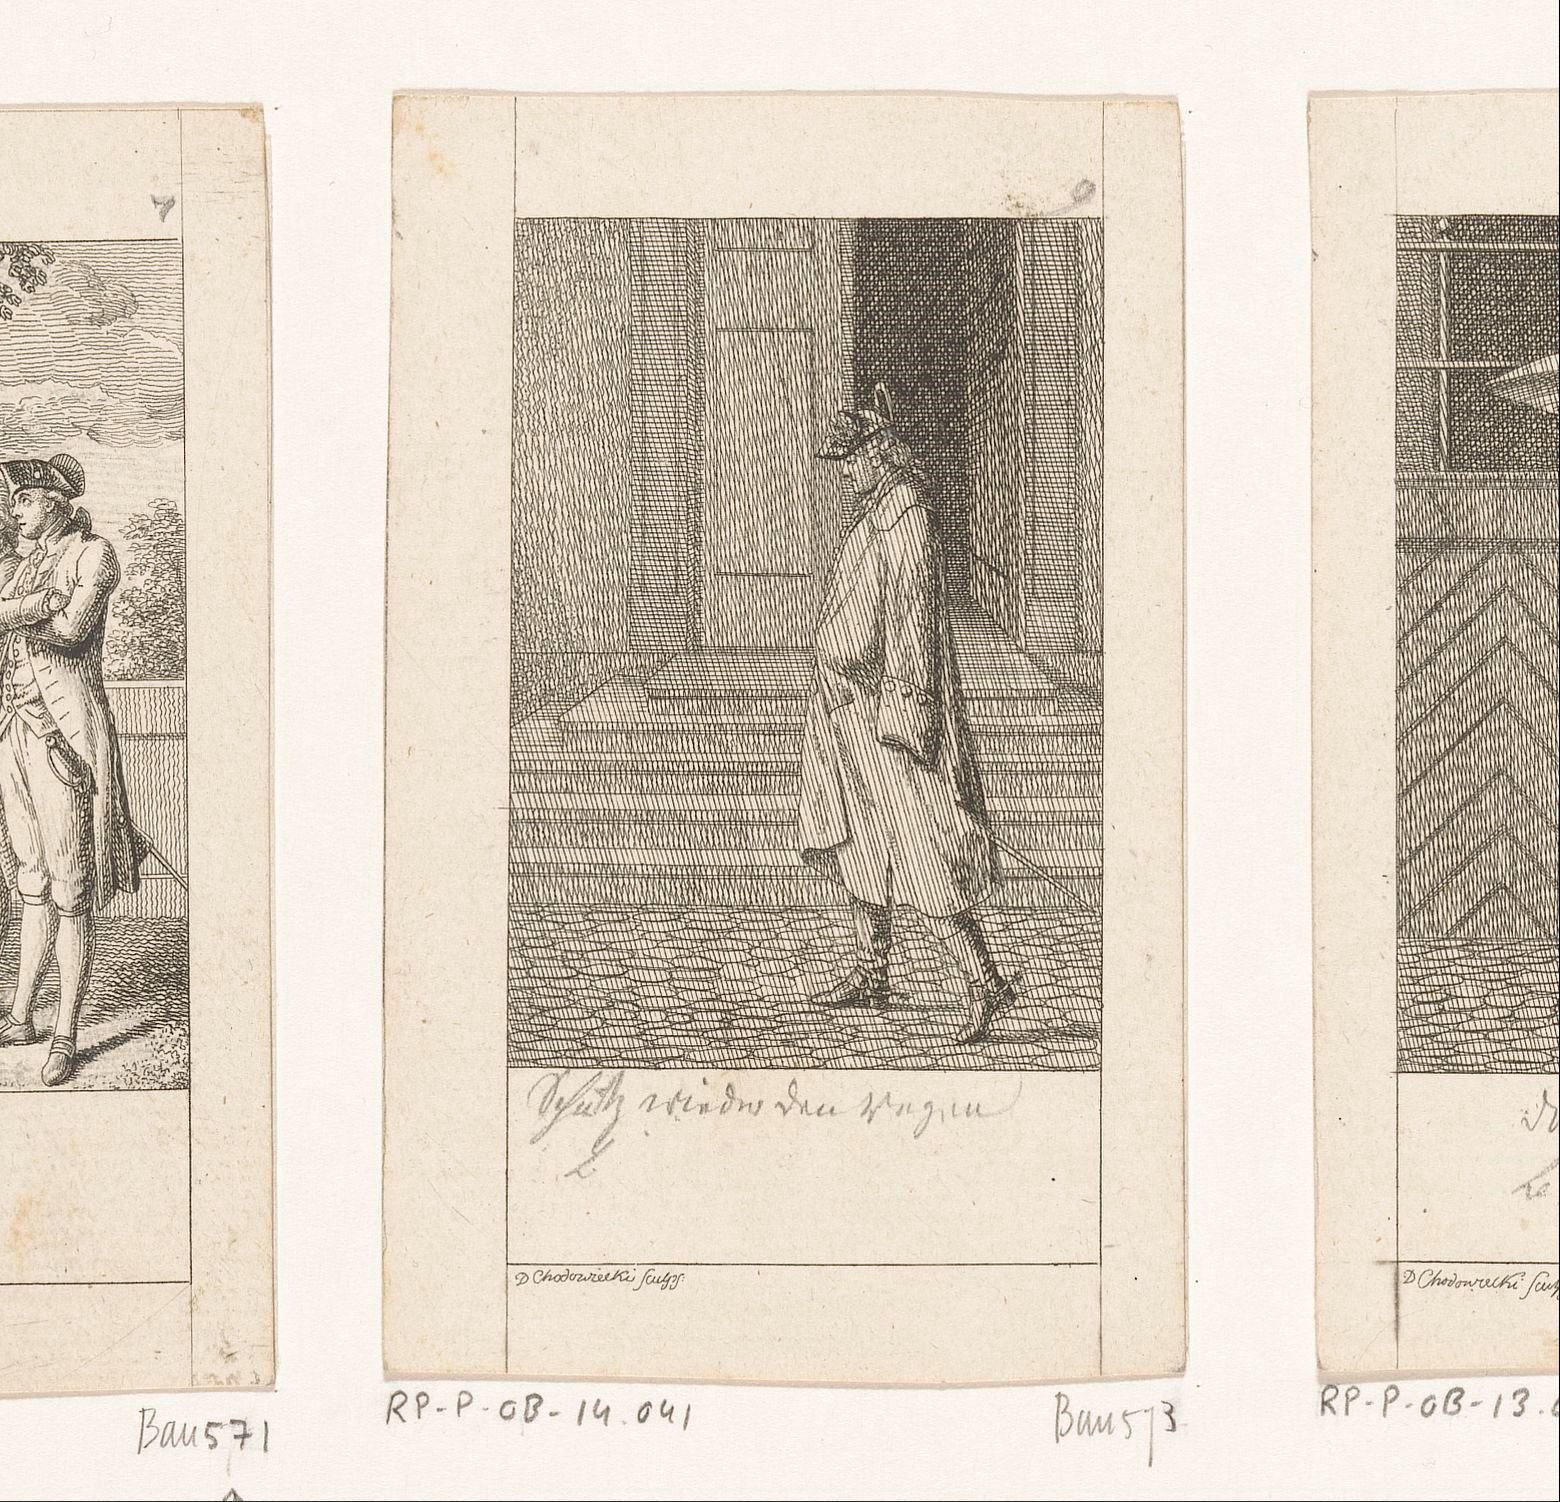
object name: print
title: Militair in de regen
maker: daniel nikolaus chodowiecki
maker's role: draughtsman, print maker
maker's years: 1726-1801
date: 1779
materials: paper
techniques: etching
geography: berlin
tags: downpour, rain shower, private soldier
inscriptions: collector's mark: Lugt 2228, inscription: ‘[...] den regen’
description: Negende prent uit een serie van twaalf taferelen die 'Natürliche und affectirte Handlungen des Lebens' (tweede serie) illustreren waarin 'natuurlijk' en 'geaffecteerd' gedrag op karikaturale wijze tegenover elkaar worden gezet. Deze taferelen zijn op een plaat geëtst. Een latere staat van deze serie, voorzien van toelichtingen door Georg Christoph Lichtenberg, is ook gebruikt in: Almanac de Goettingue pour l'année 1780. Göttingen: Johann Christian Dieterich.